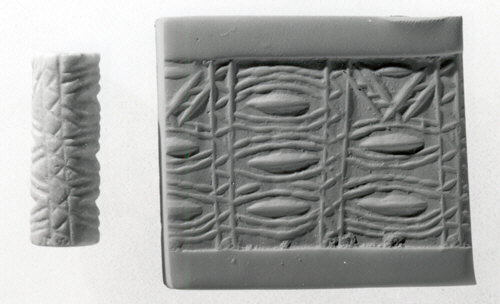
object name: cylinder seal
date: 3100-2700 BCE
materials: marble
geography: mesopotamia